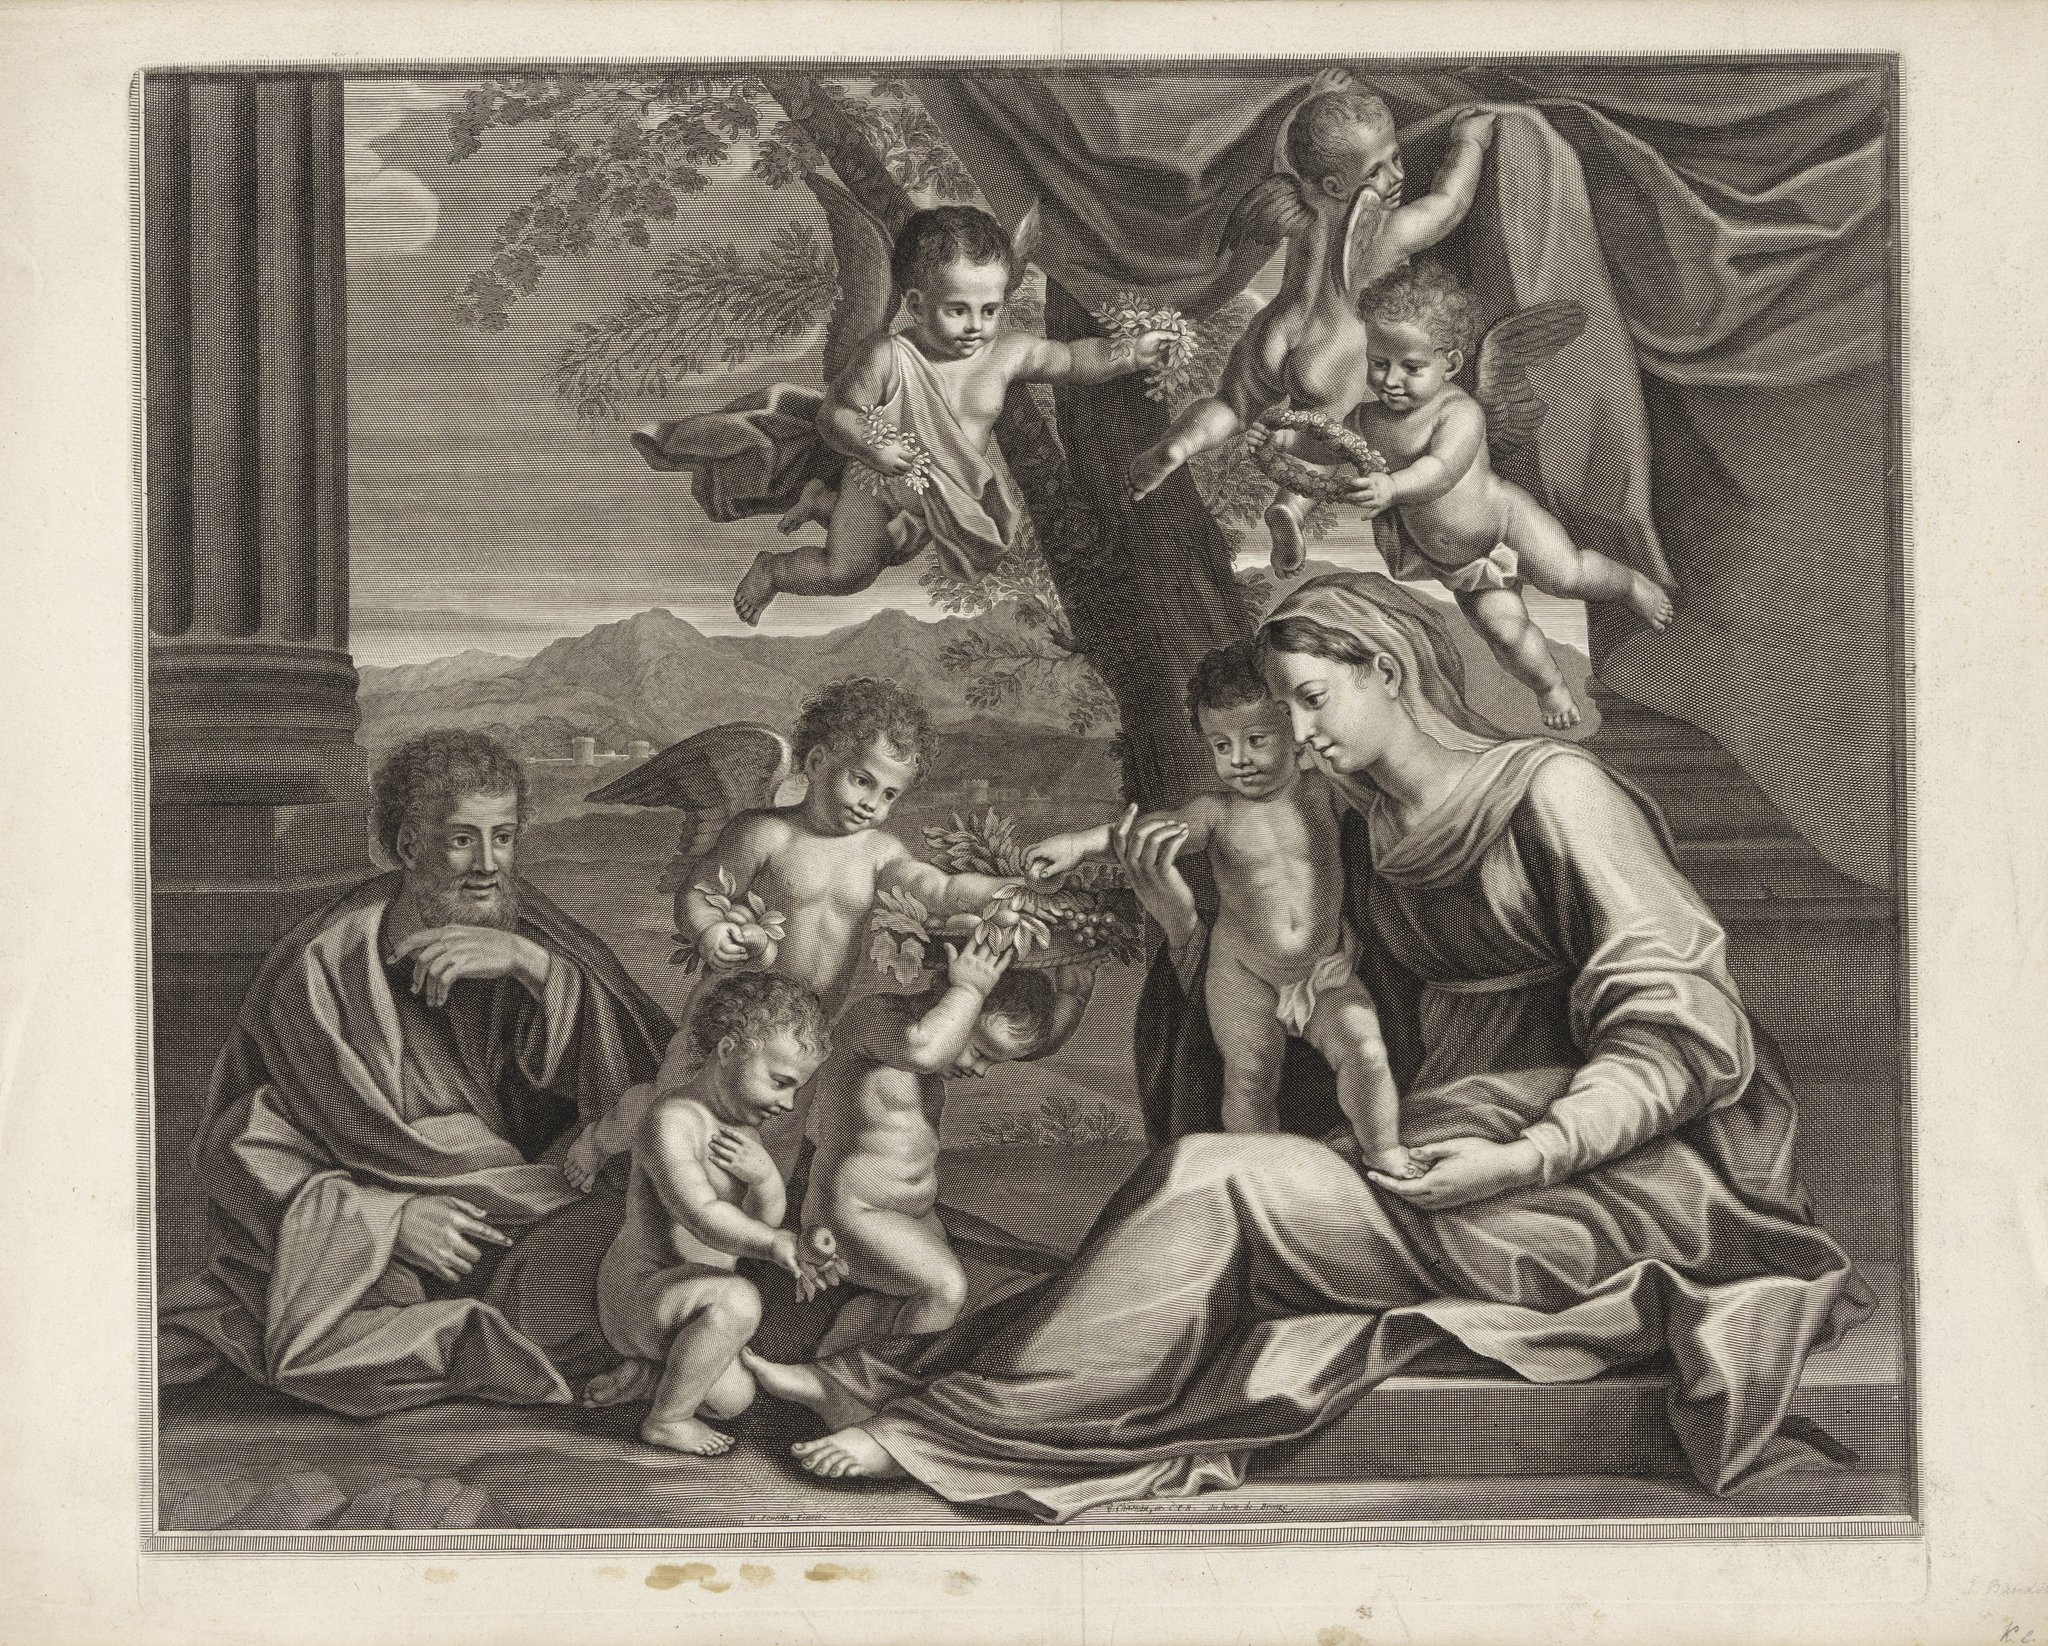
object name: print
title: Heilige Familie met putti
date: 1648-1711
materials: paper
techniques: engraving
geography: france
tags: holy family, and derived representations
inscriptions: collector's mark: Lugt 240